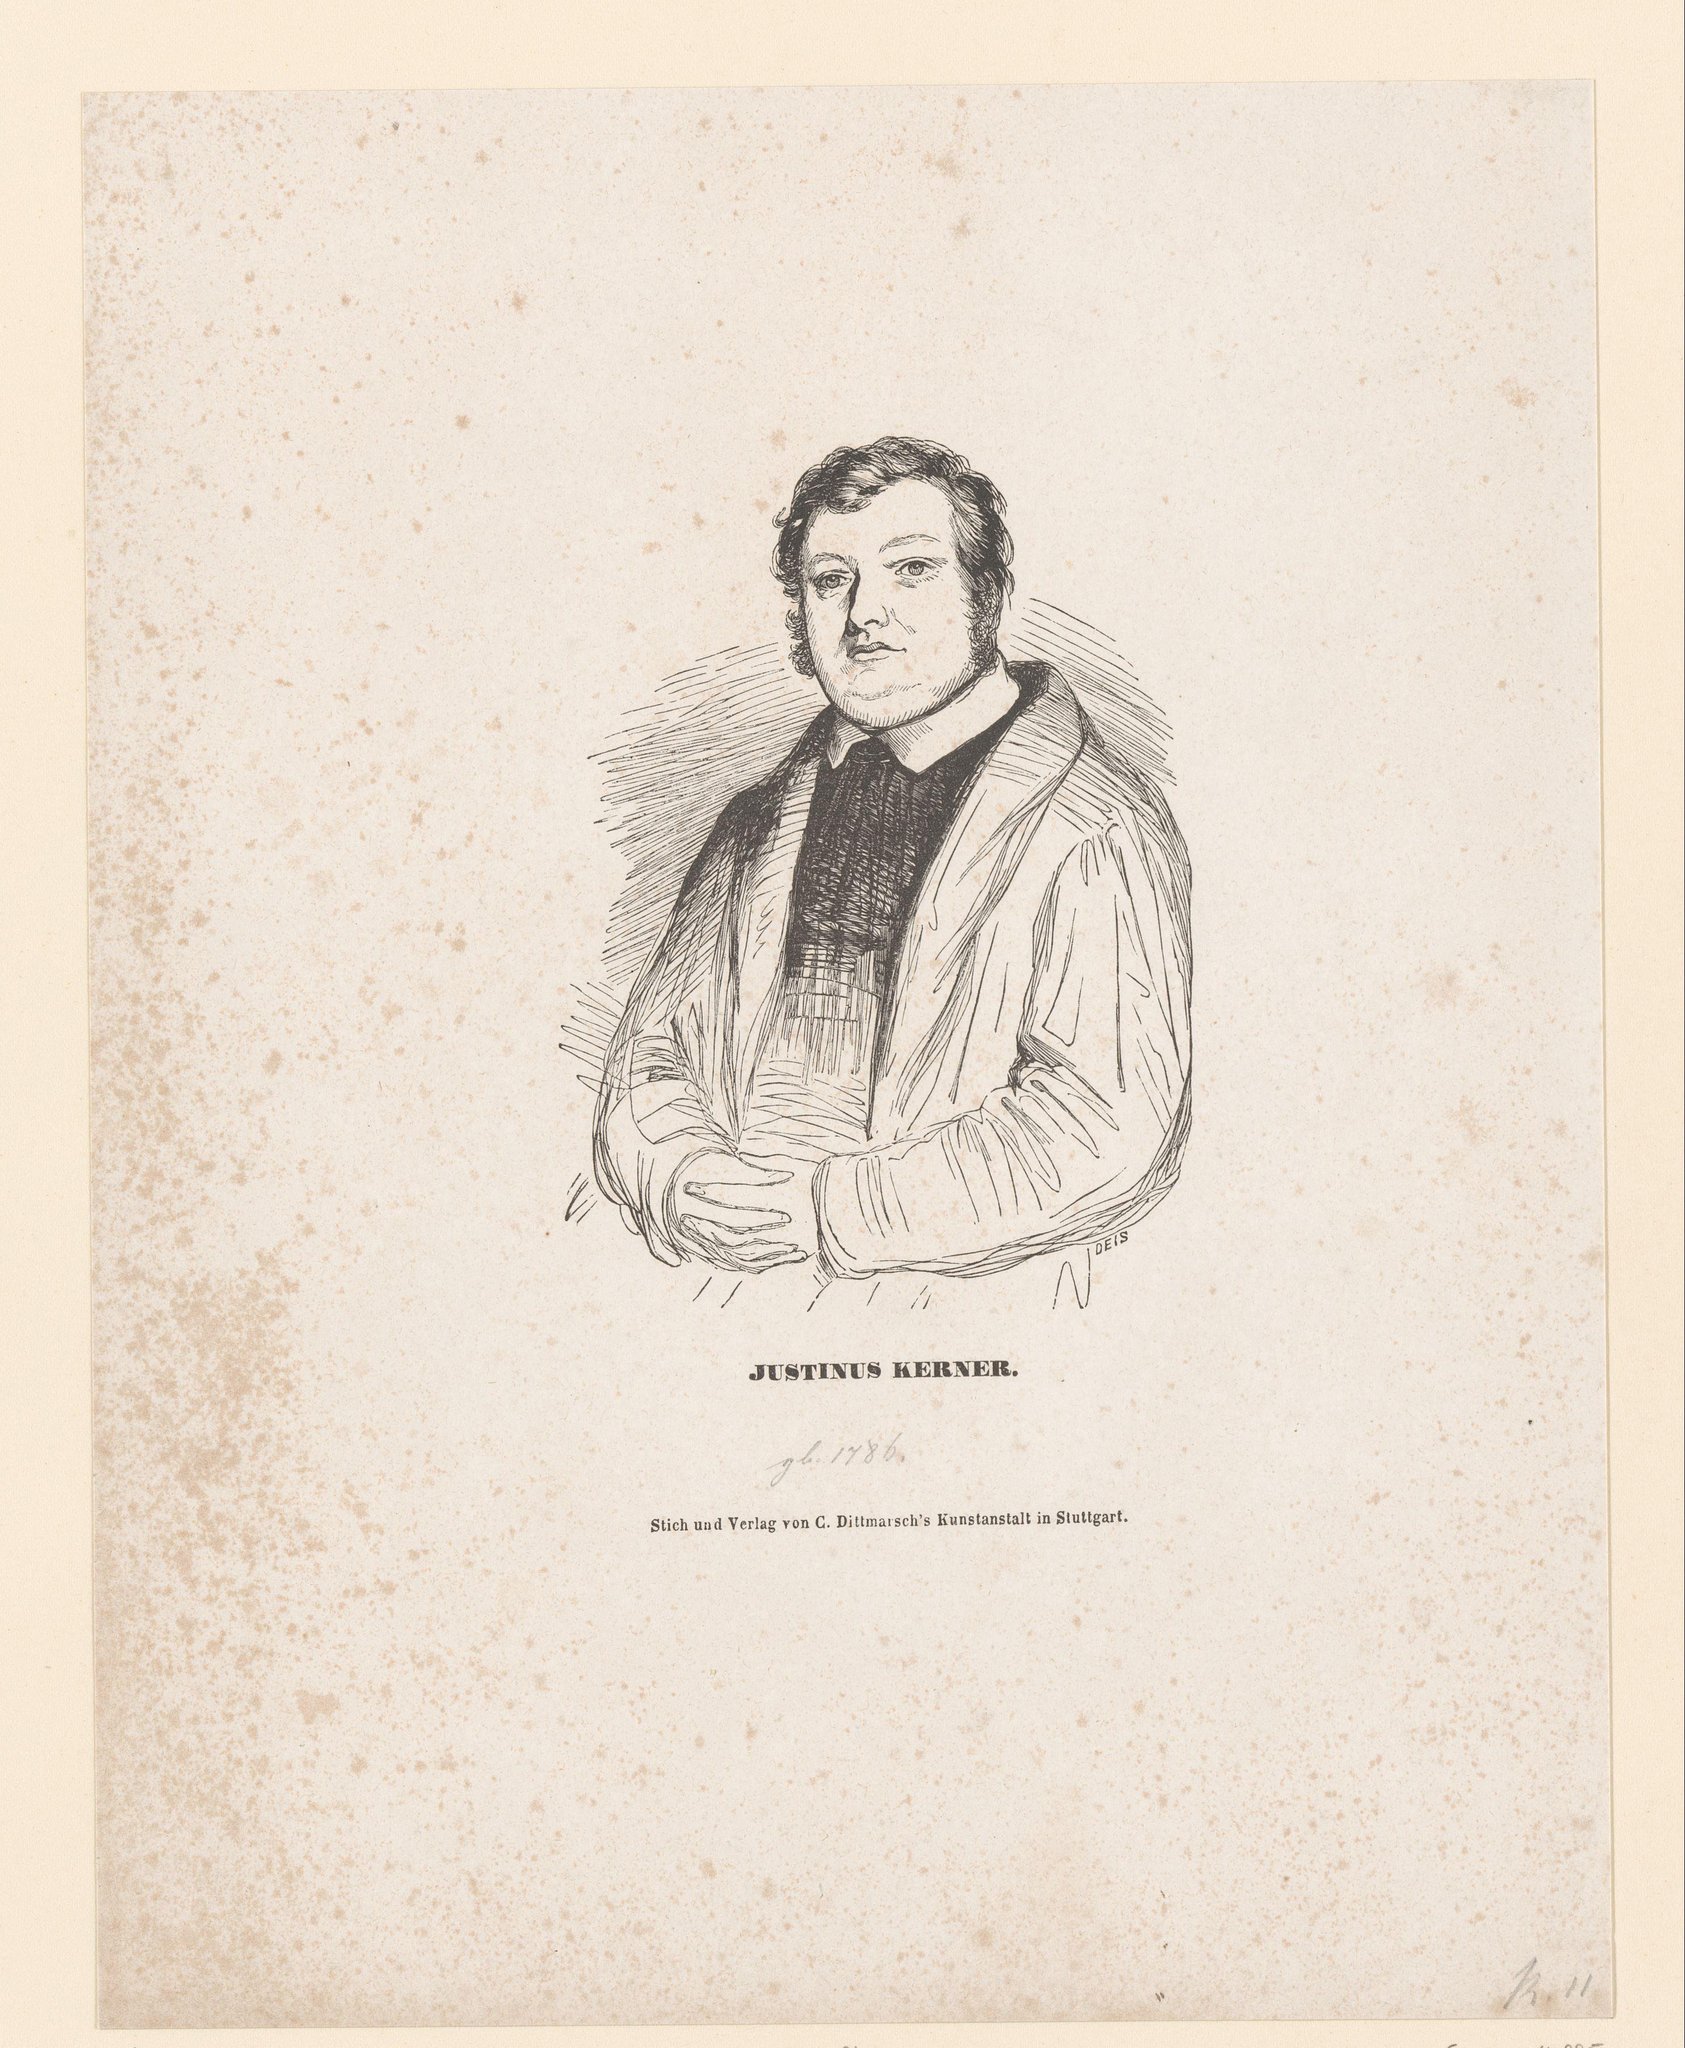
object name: print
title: Portret van Justinus Andreas Christian Kerner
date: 1824-1899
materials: paper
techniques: engraving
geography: stuttgart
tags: historical persons, writer, poet, author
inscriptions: collector's mark: Lugt 2228